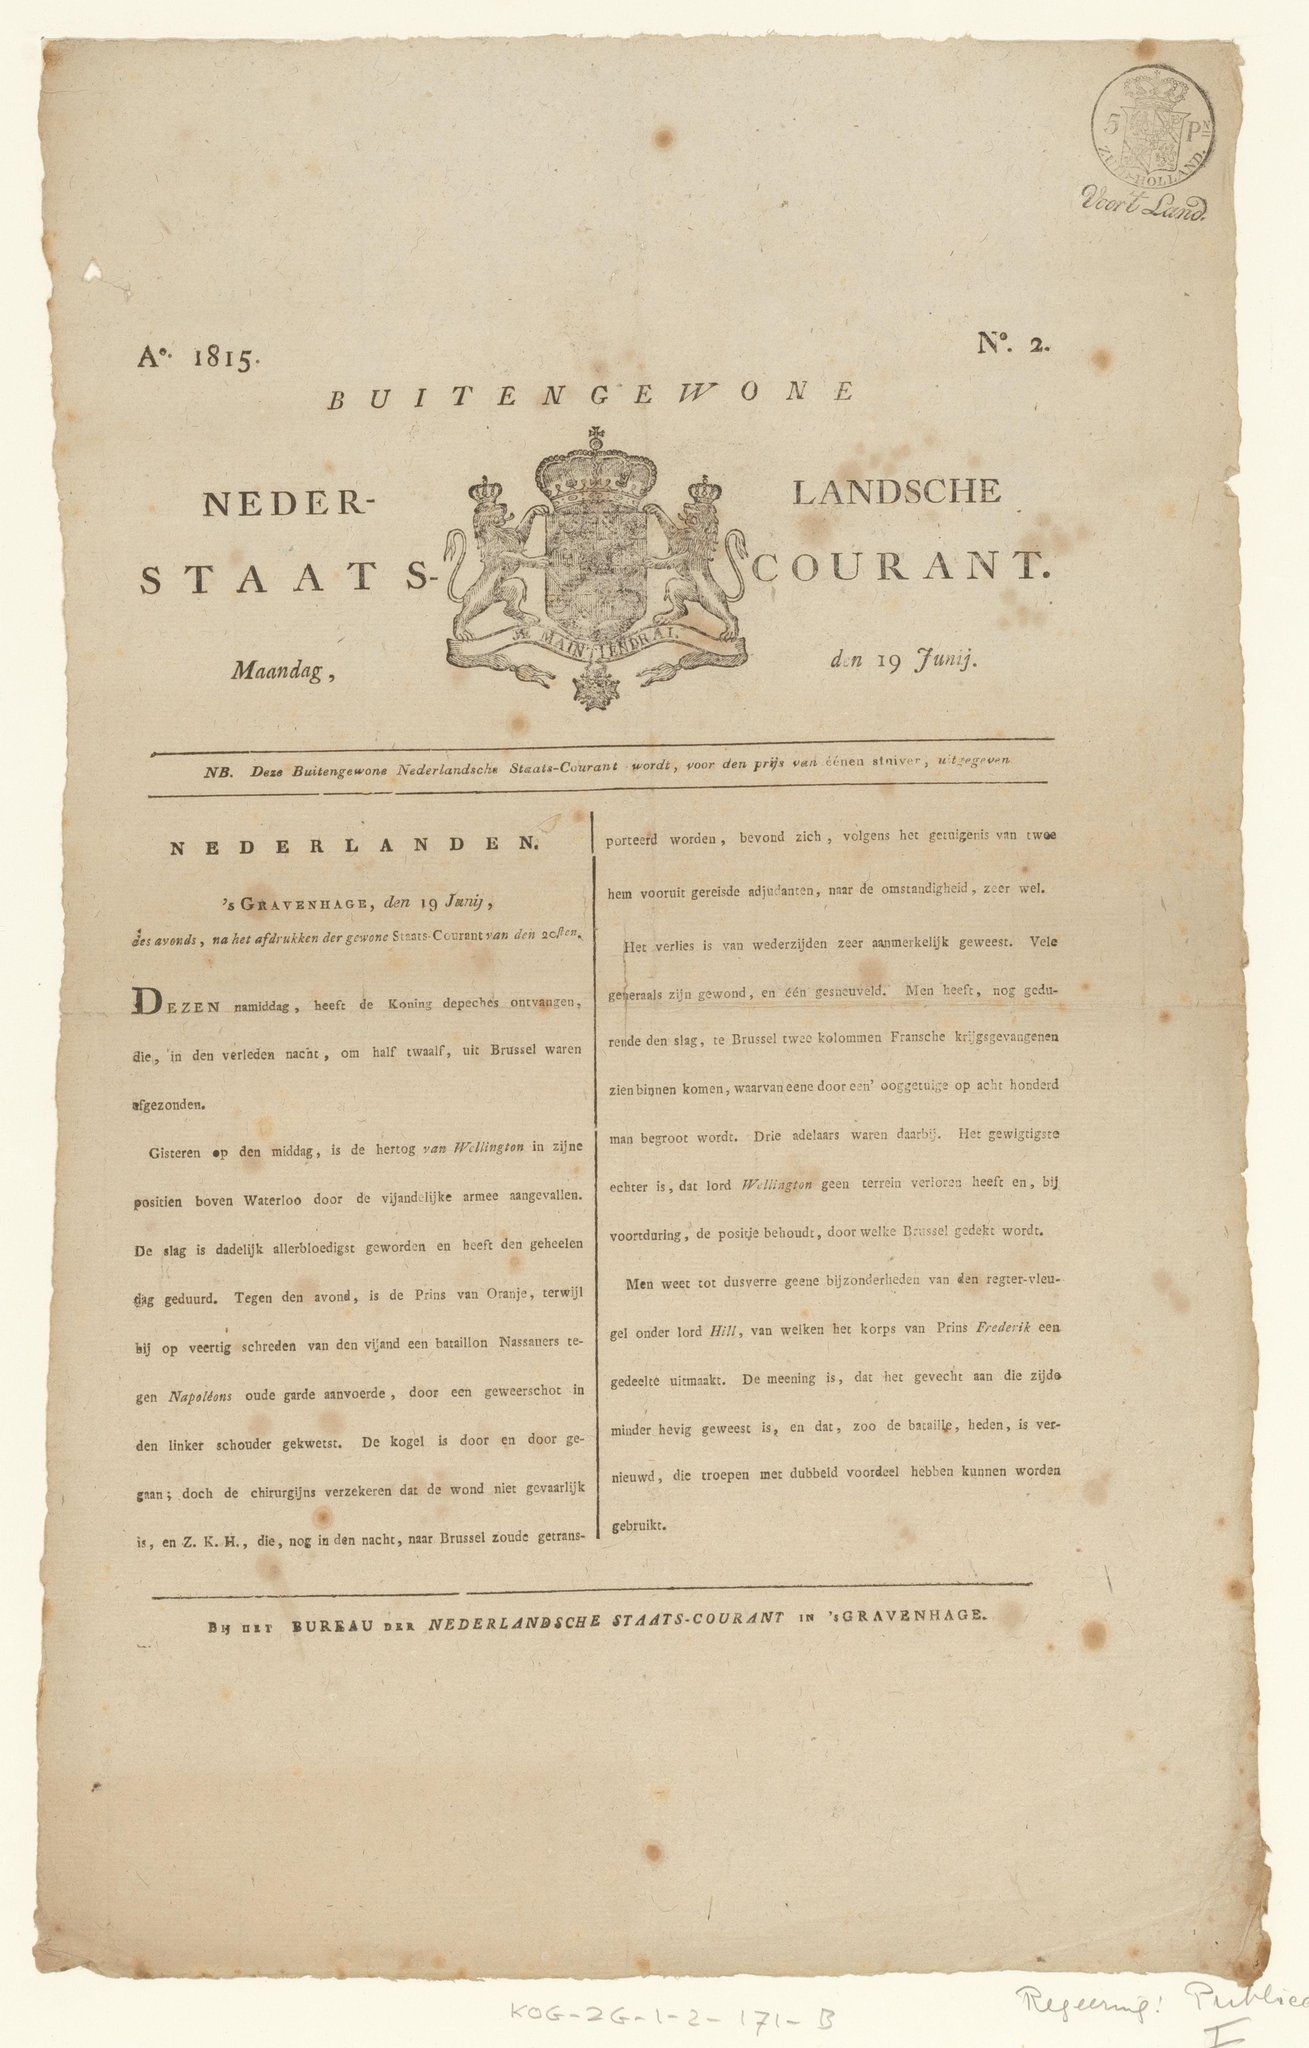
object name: newspaper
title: Buitengewone Nederlandsche Staatscourant, 19 juni 1815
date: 1815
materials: paper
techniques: letterpress printing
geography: the hague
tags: national government, newspaper, news-sheet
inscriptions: collector's mark, collector's mark: Lugt 1641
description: Exemplaar van de krant 'Buitengewone Nederlandsche Staatscourant' van 19 juni 1815. Over de slag bij Waterloo. Gedrukte tekst met bovenaan het landswapen. Rechtsboven een stempel betaalde accijnzen. Onderwerpsrubrieken binnen de Atlas Zeden en Gewoonten: Regeering, Publicaties.